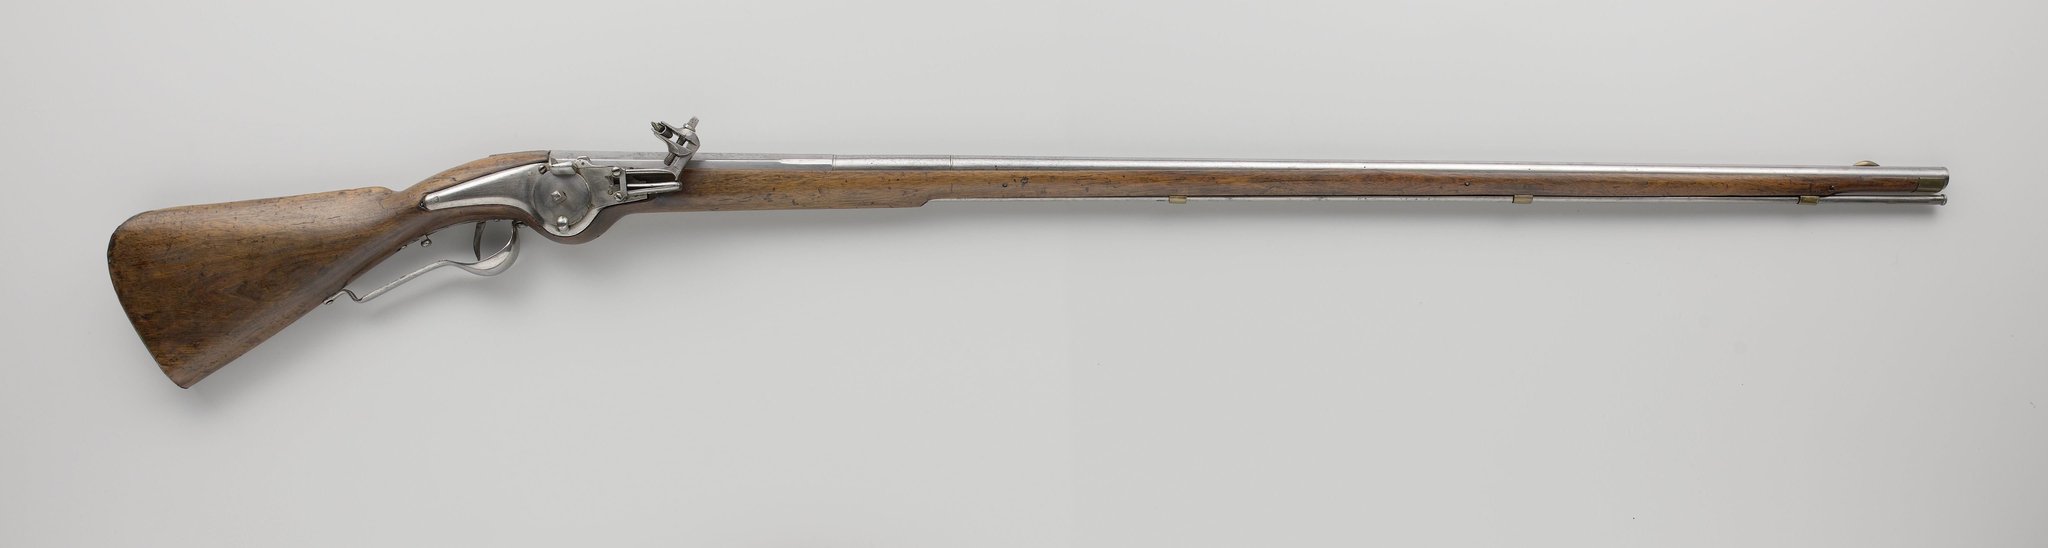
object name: musket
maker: Anonymous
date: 1650-1675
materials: brass, iron, wood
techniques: cutting, forging, striking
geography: utrecht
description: Caliver, made in Utrecht, third quarter 17th century.